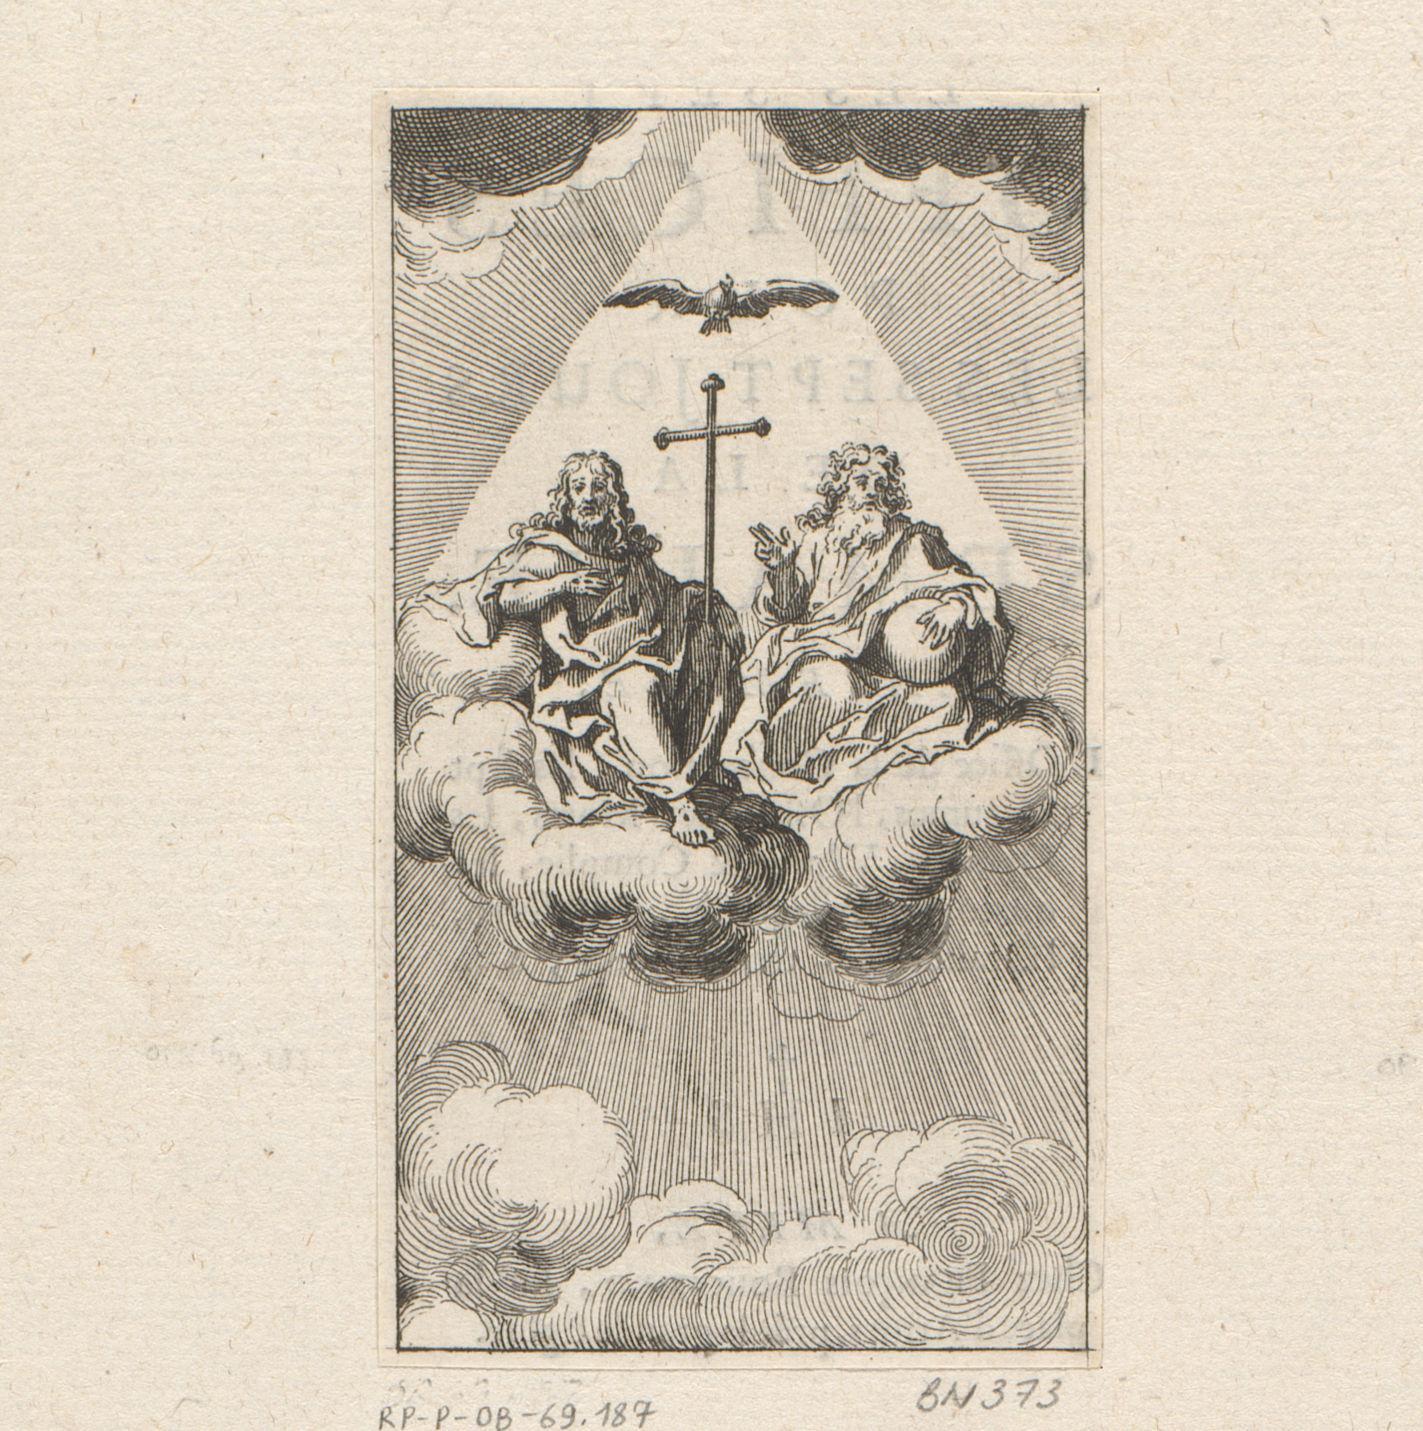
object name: print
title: Drieëenheid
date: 1683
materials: paper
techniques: etching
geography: france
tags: trinity in which god the father and christ are represented as persons, the holy ghost as dove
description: Prent uit: Heures dédiées à la Dauphine. Metz: François Bouchard, 1683.